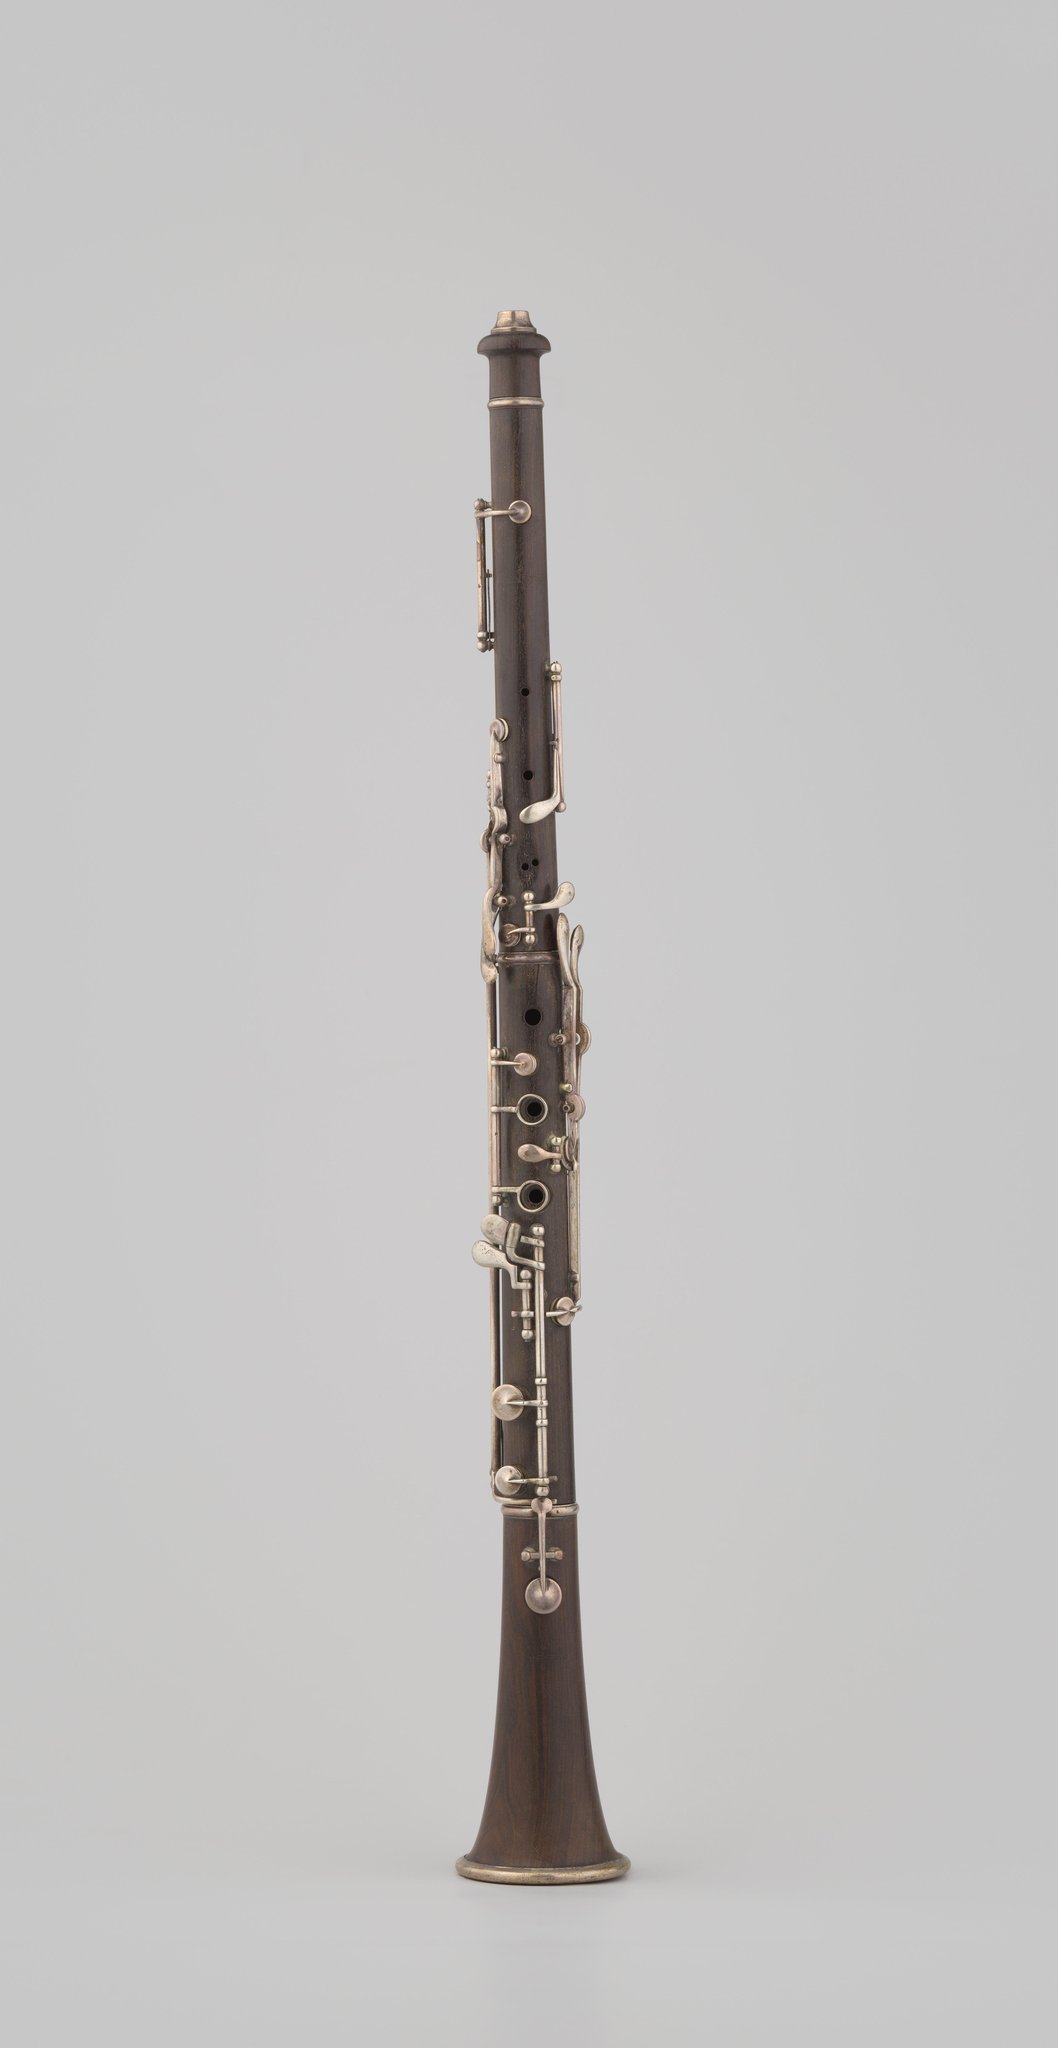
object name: musical instrument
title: Oboe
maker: christian gottfried geisler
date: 1850-1899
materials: wood, leather, silver, velvet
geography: amsterdam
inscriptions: mark: ‘[ster] / GEISLER / AMSTERDAM / [ster]’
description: Hobo van palmhout met twaalf zilveren kleppen en een zilveren vingersteun. Het derde gat is dubbel. De hobo heeft vier zilveren ringen (een op het bovenste gedeelte, een op het middelste deel en twee op het onderste gedeelte). Gemarkeerd op alle drie de delen: [ster] / GEISLER / AMSTERDAM / [ster]. De hobo zit in een houten koffer bedekt met leer en fluweel aan de binnenkant. In de koffer zit een extra stemstukje om te kunnen wisselen en een kartonnen doosje met één riet erin.